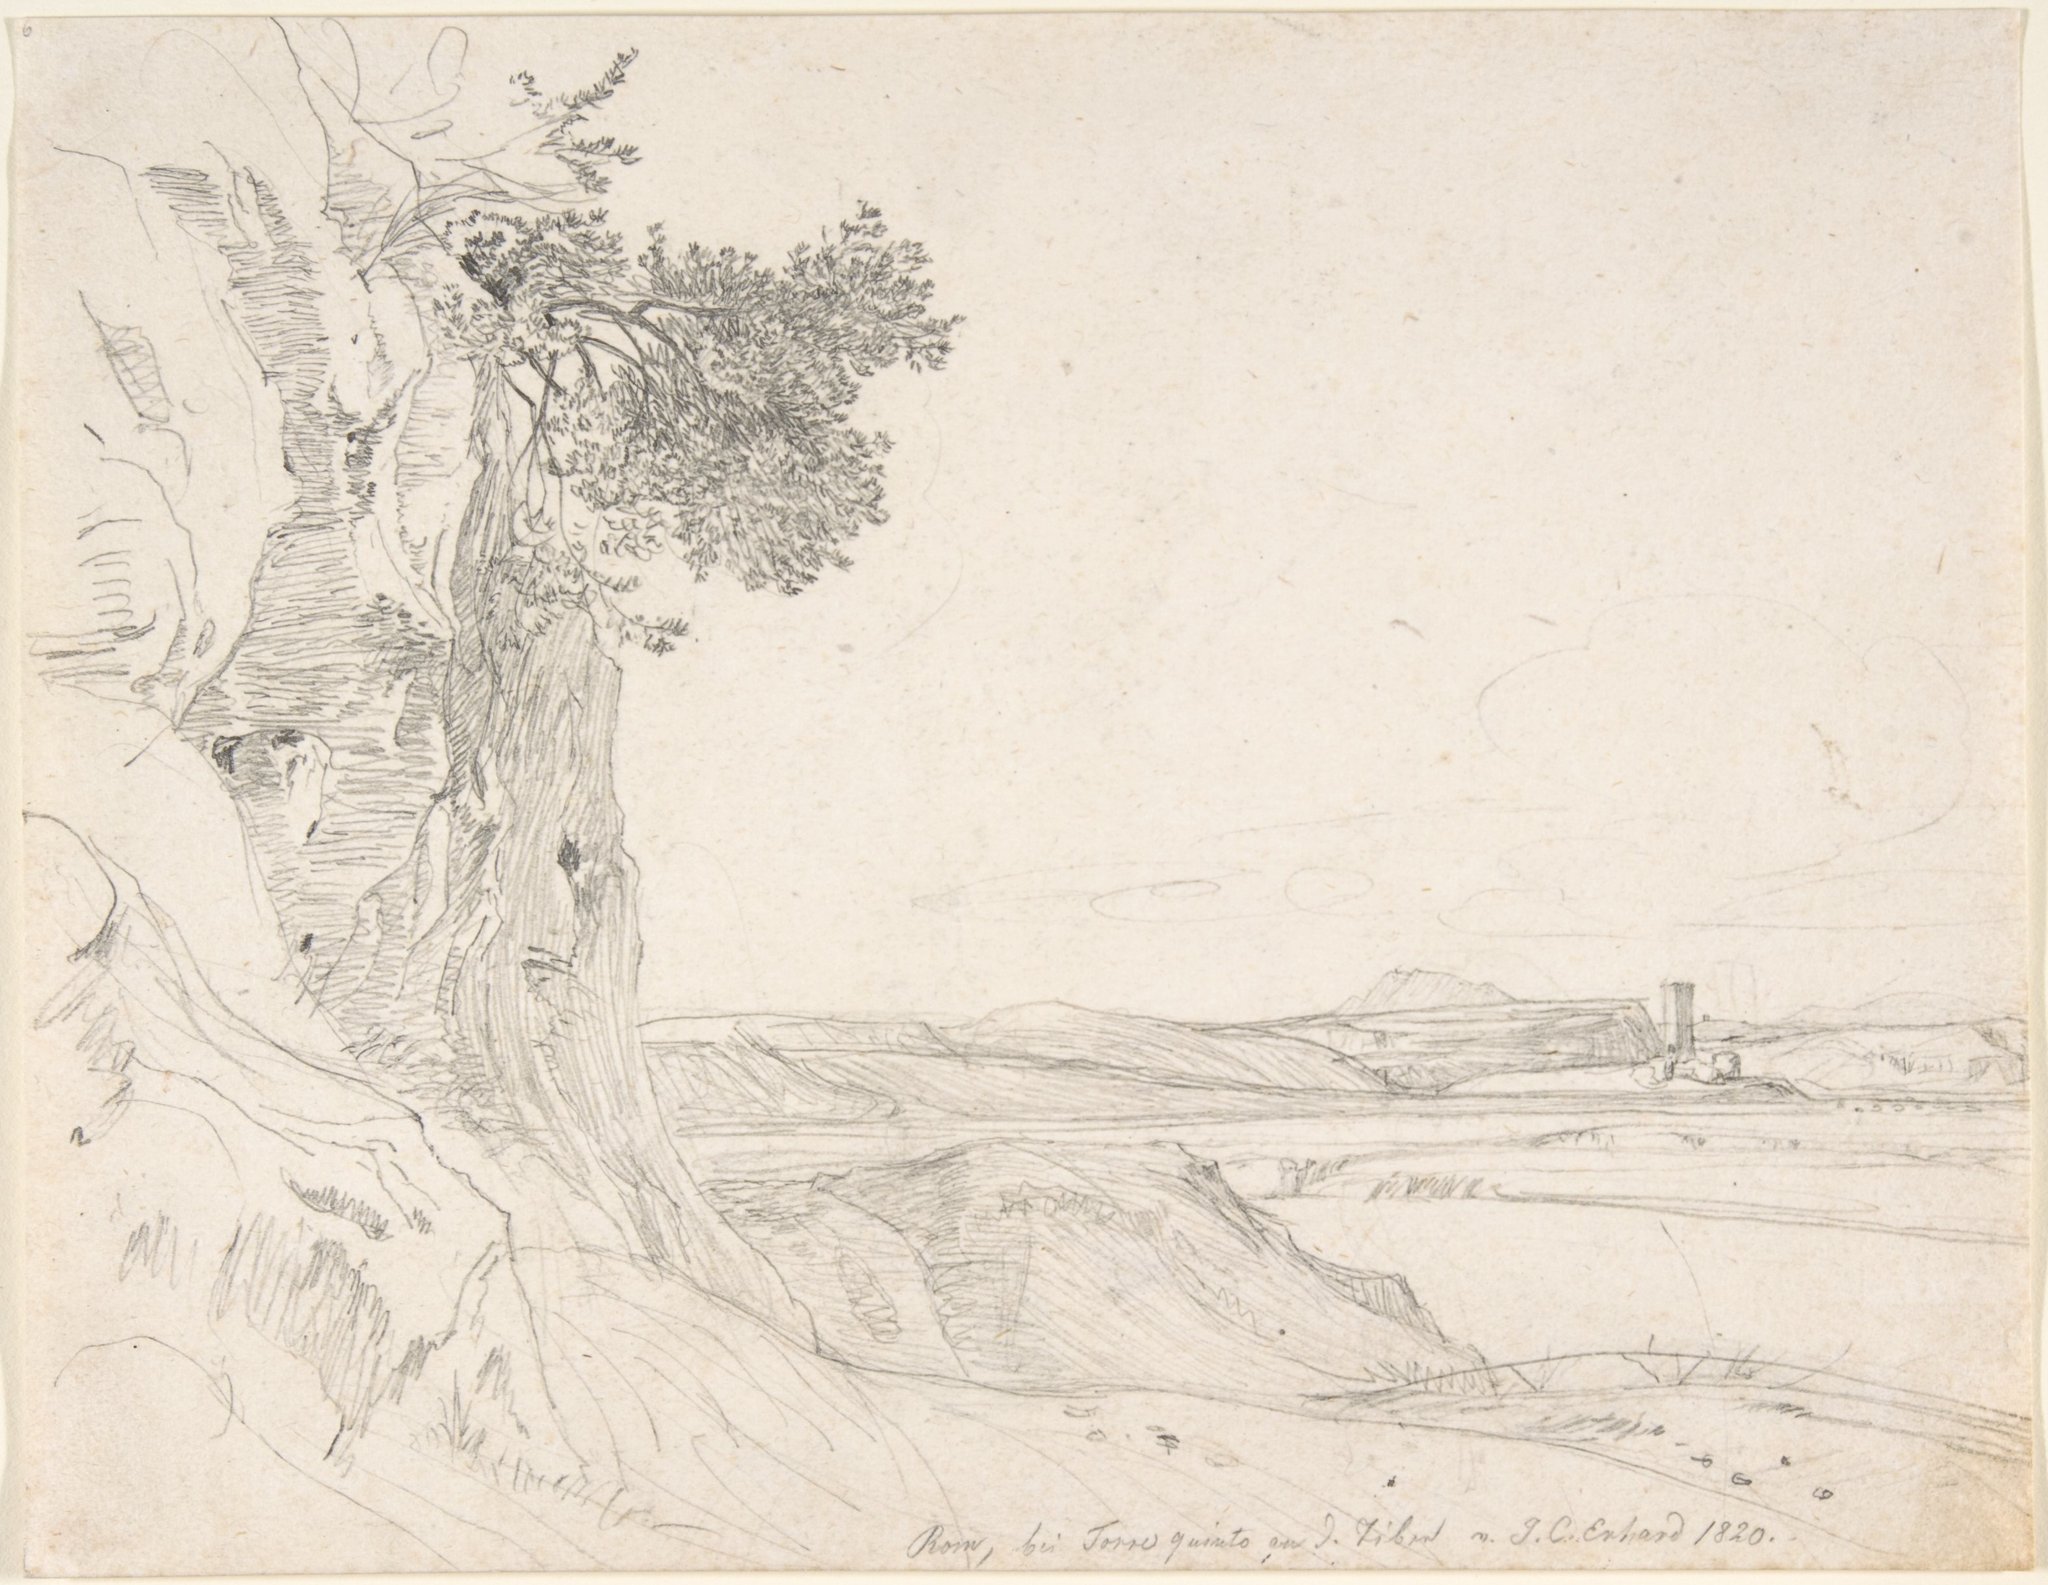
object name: drawing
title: A View of the Roman Campagna with the Tiber near Torre Quinto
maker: johann christoph erhard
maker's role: artist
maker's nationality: german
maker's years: 1795-1822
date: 1820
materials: graphite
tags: landscapes,trees